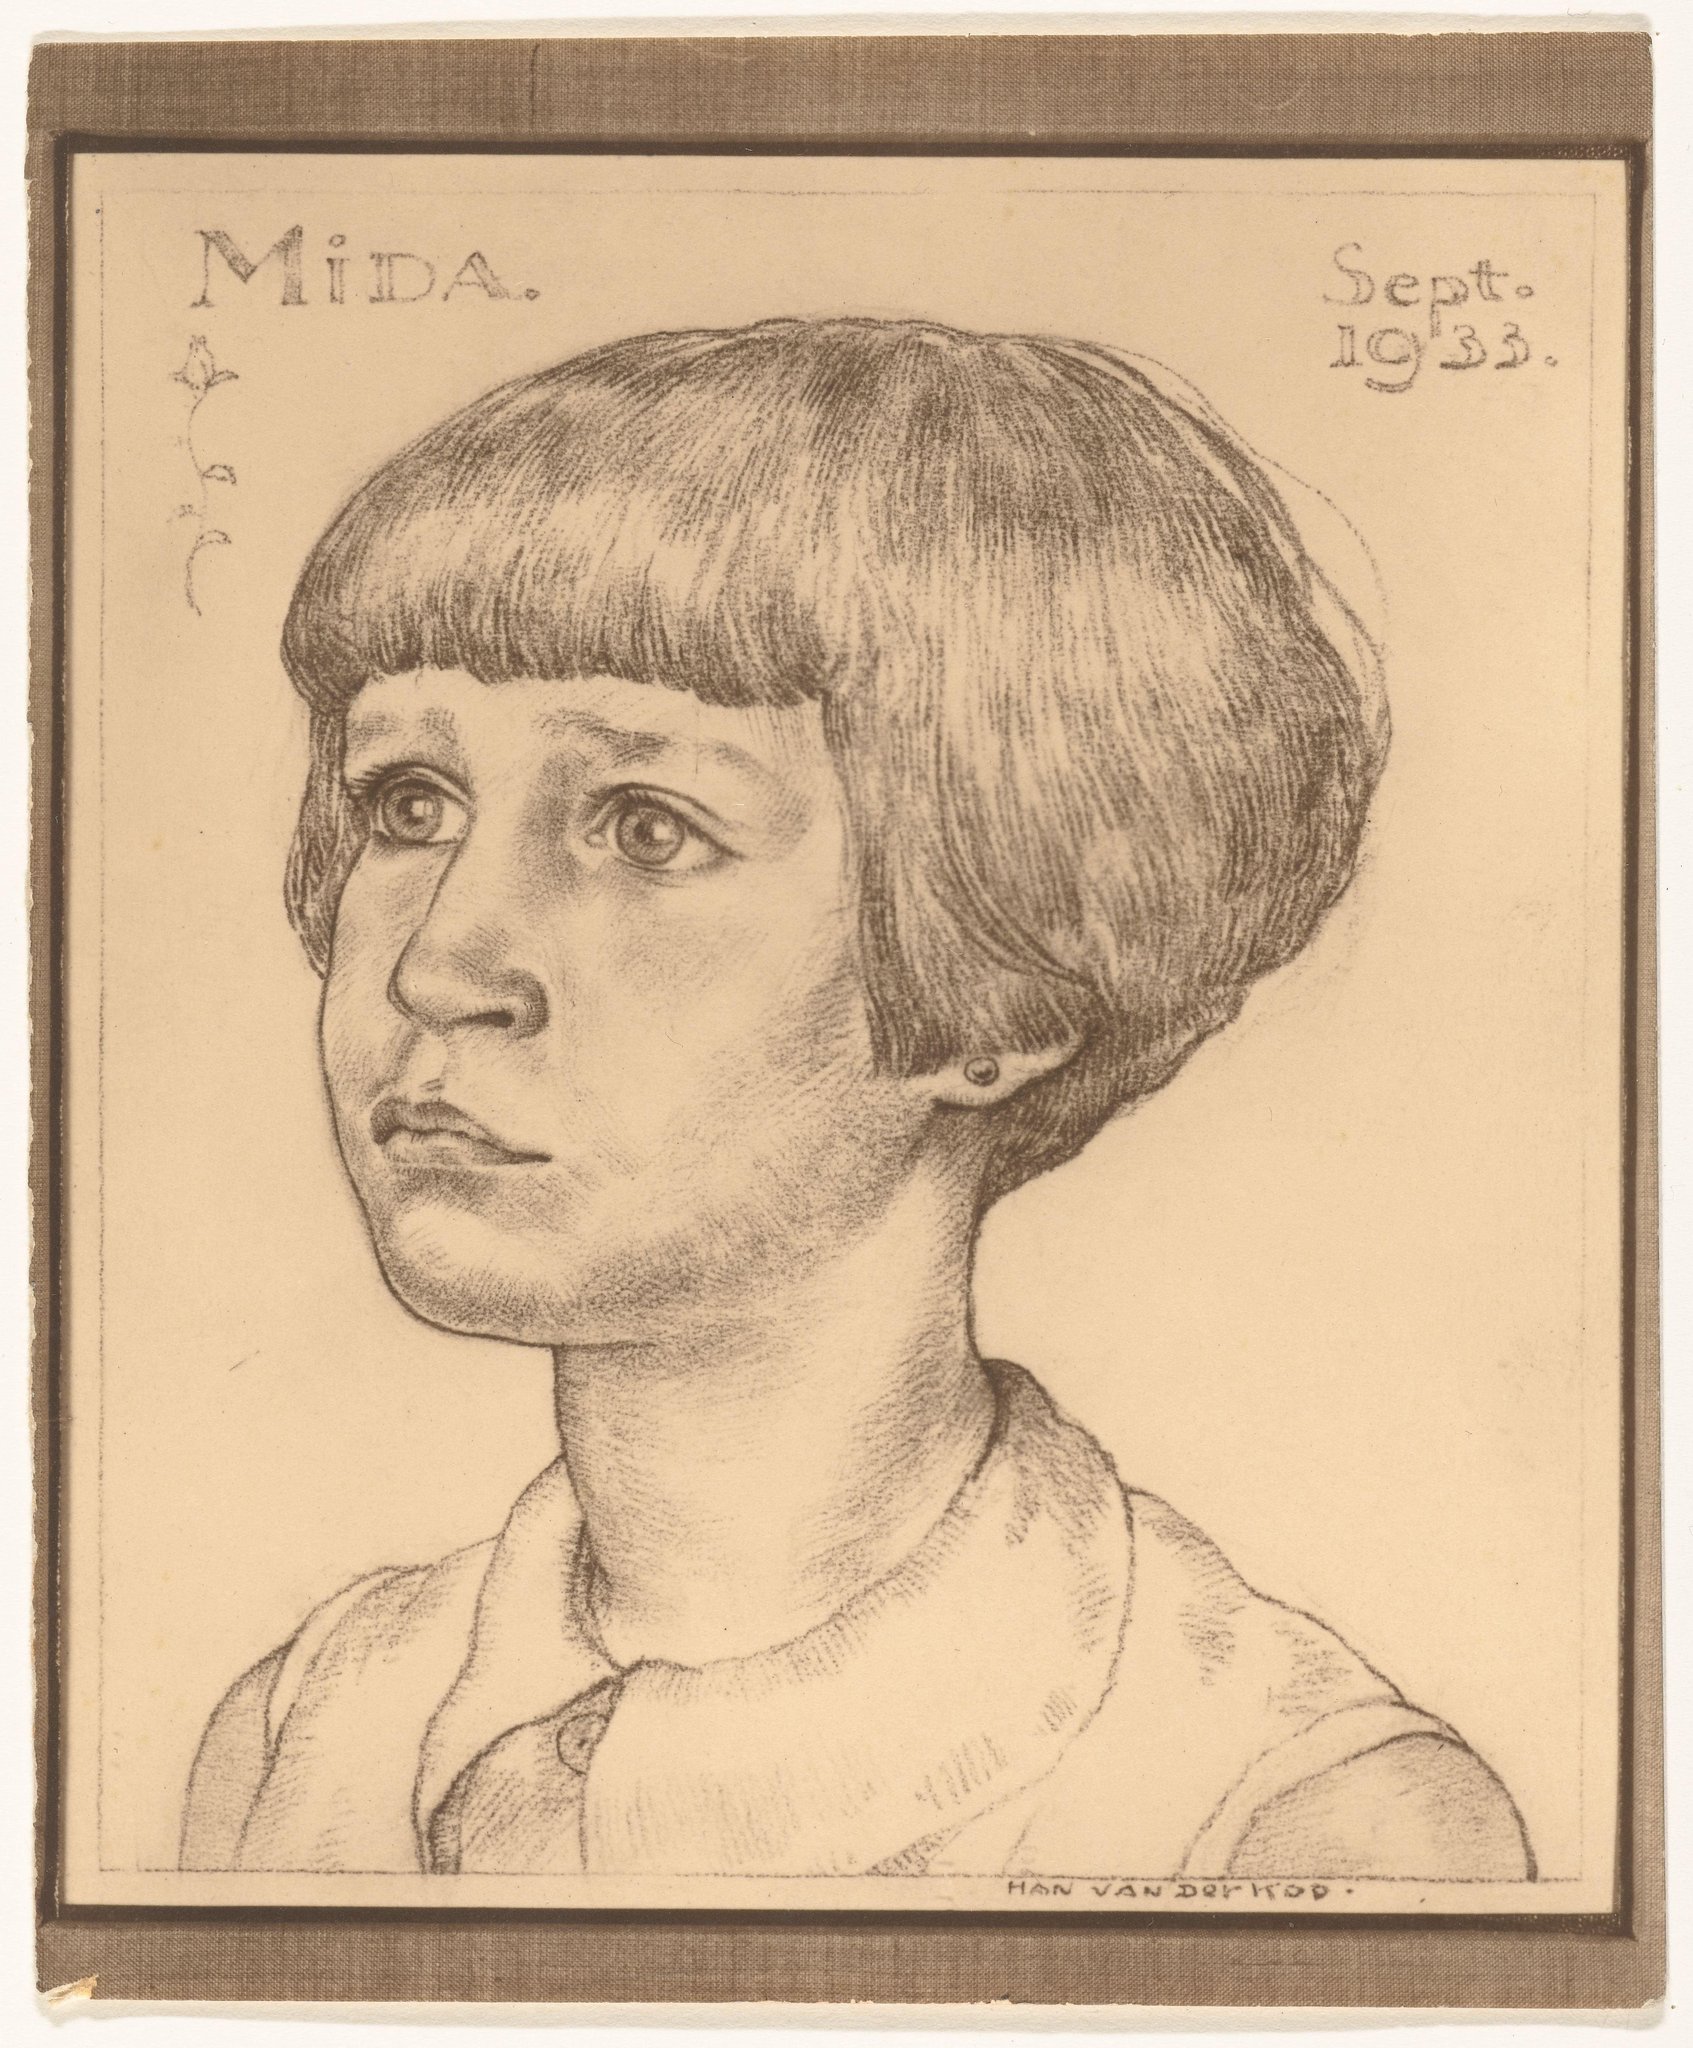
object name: photograph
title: Mida sept 1933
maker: adriaan bijl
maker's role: fotograaf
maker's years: 1874-1967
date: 1933-1960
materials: paper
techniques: gelatin silver print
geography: amsterdam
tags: drawing, historical persons - bb - woman, girl (child between toddler and youth), netherlands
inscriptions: title: ‘Mida sept 1933’, annotation: ‘Reproductie van nagelaten werk van Han van der Kop’